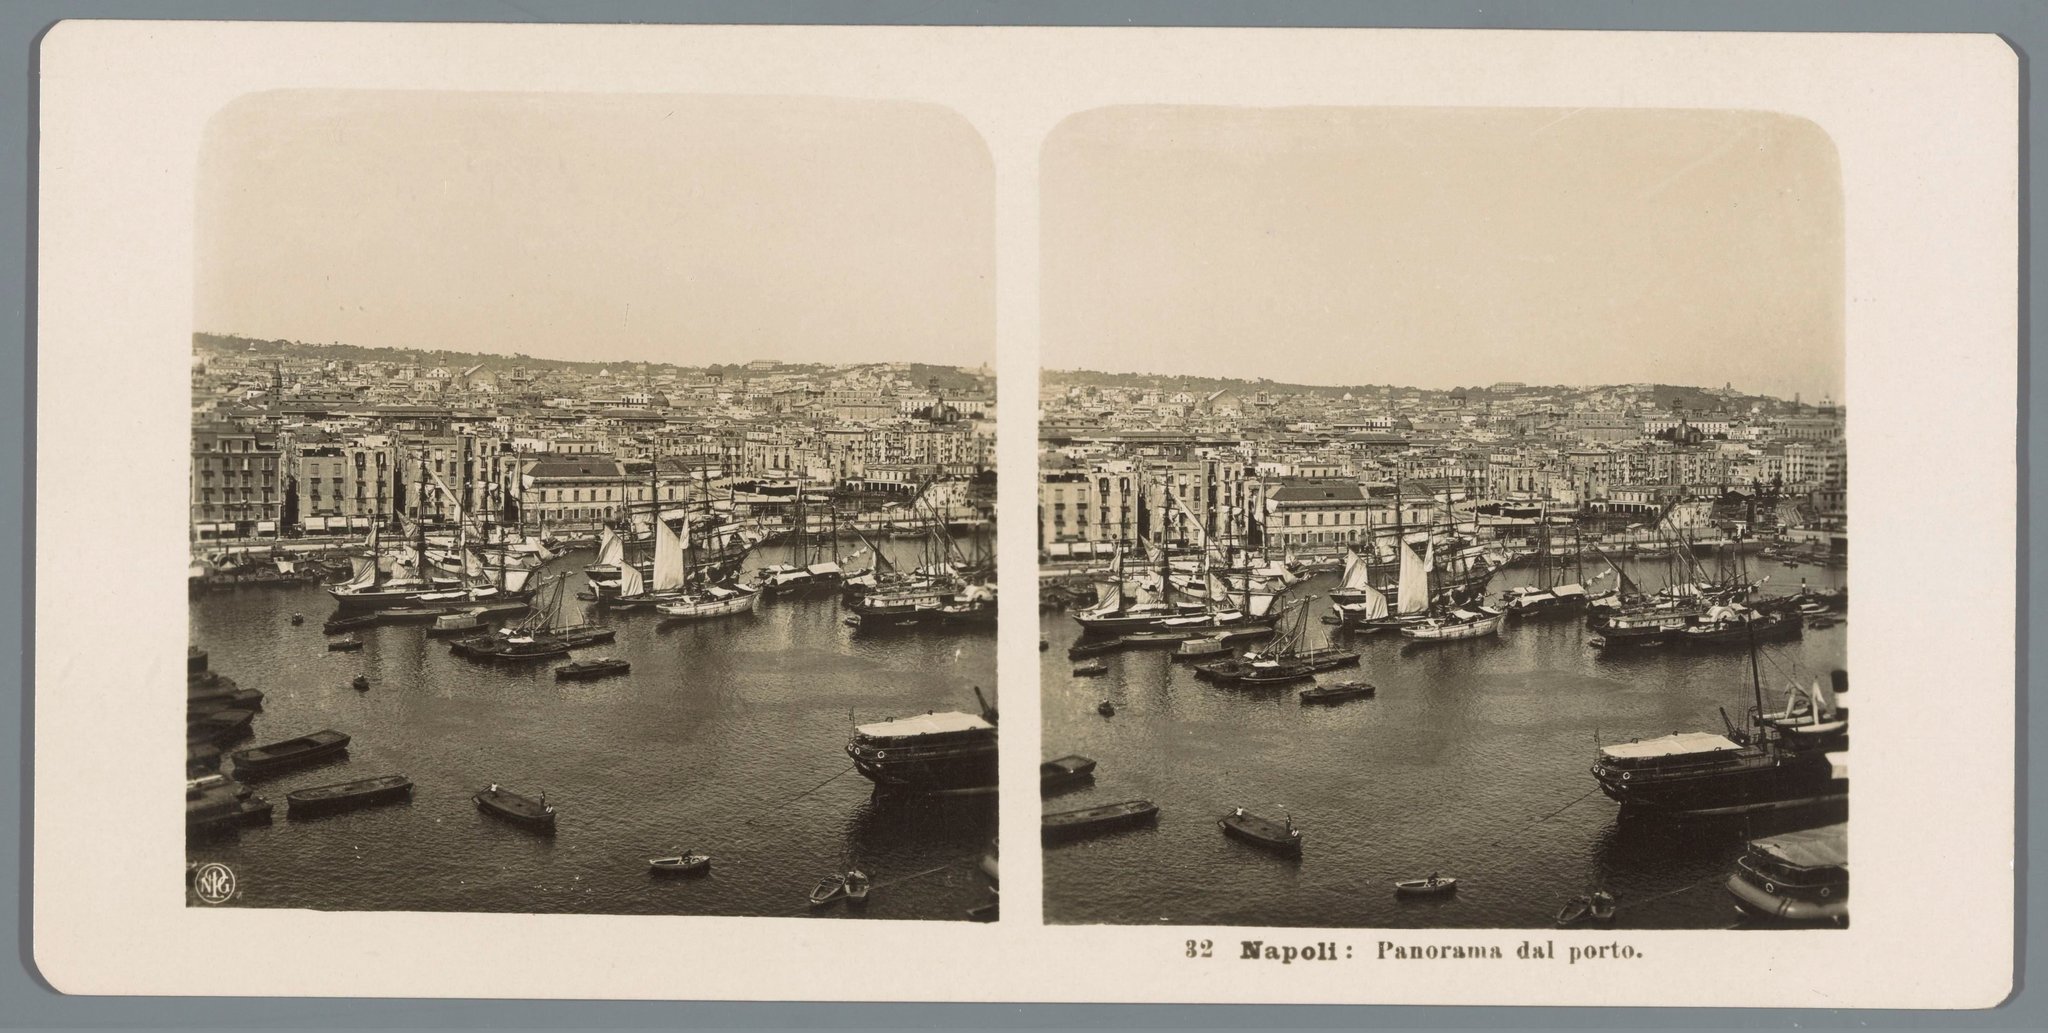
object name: stereograph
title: Napoli: Panorama dal porto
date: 1900-1910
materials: cardboard, photographic support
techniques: gelatin silver print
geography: naples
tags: harbour, city-view in general; 'veduta', ships (in general), naples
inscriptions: inscription: ‘NPG’, number: ‘32’